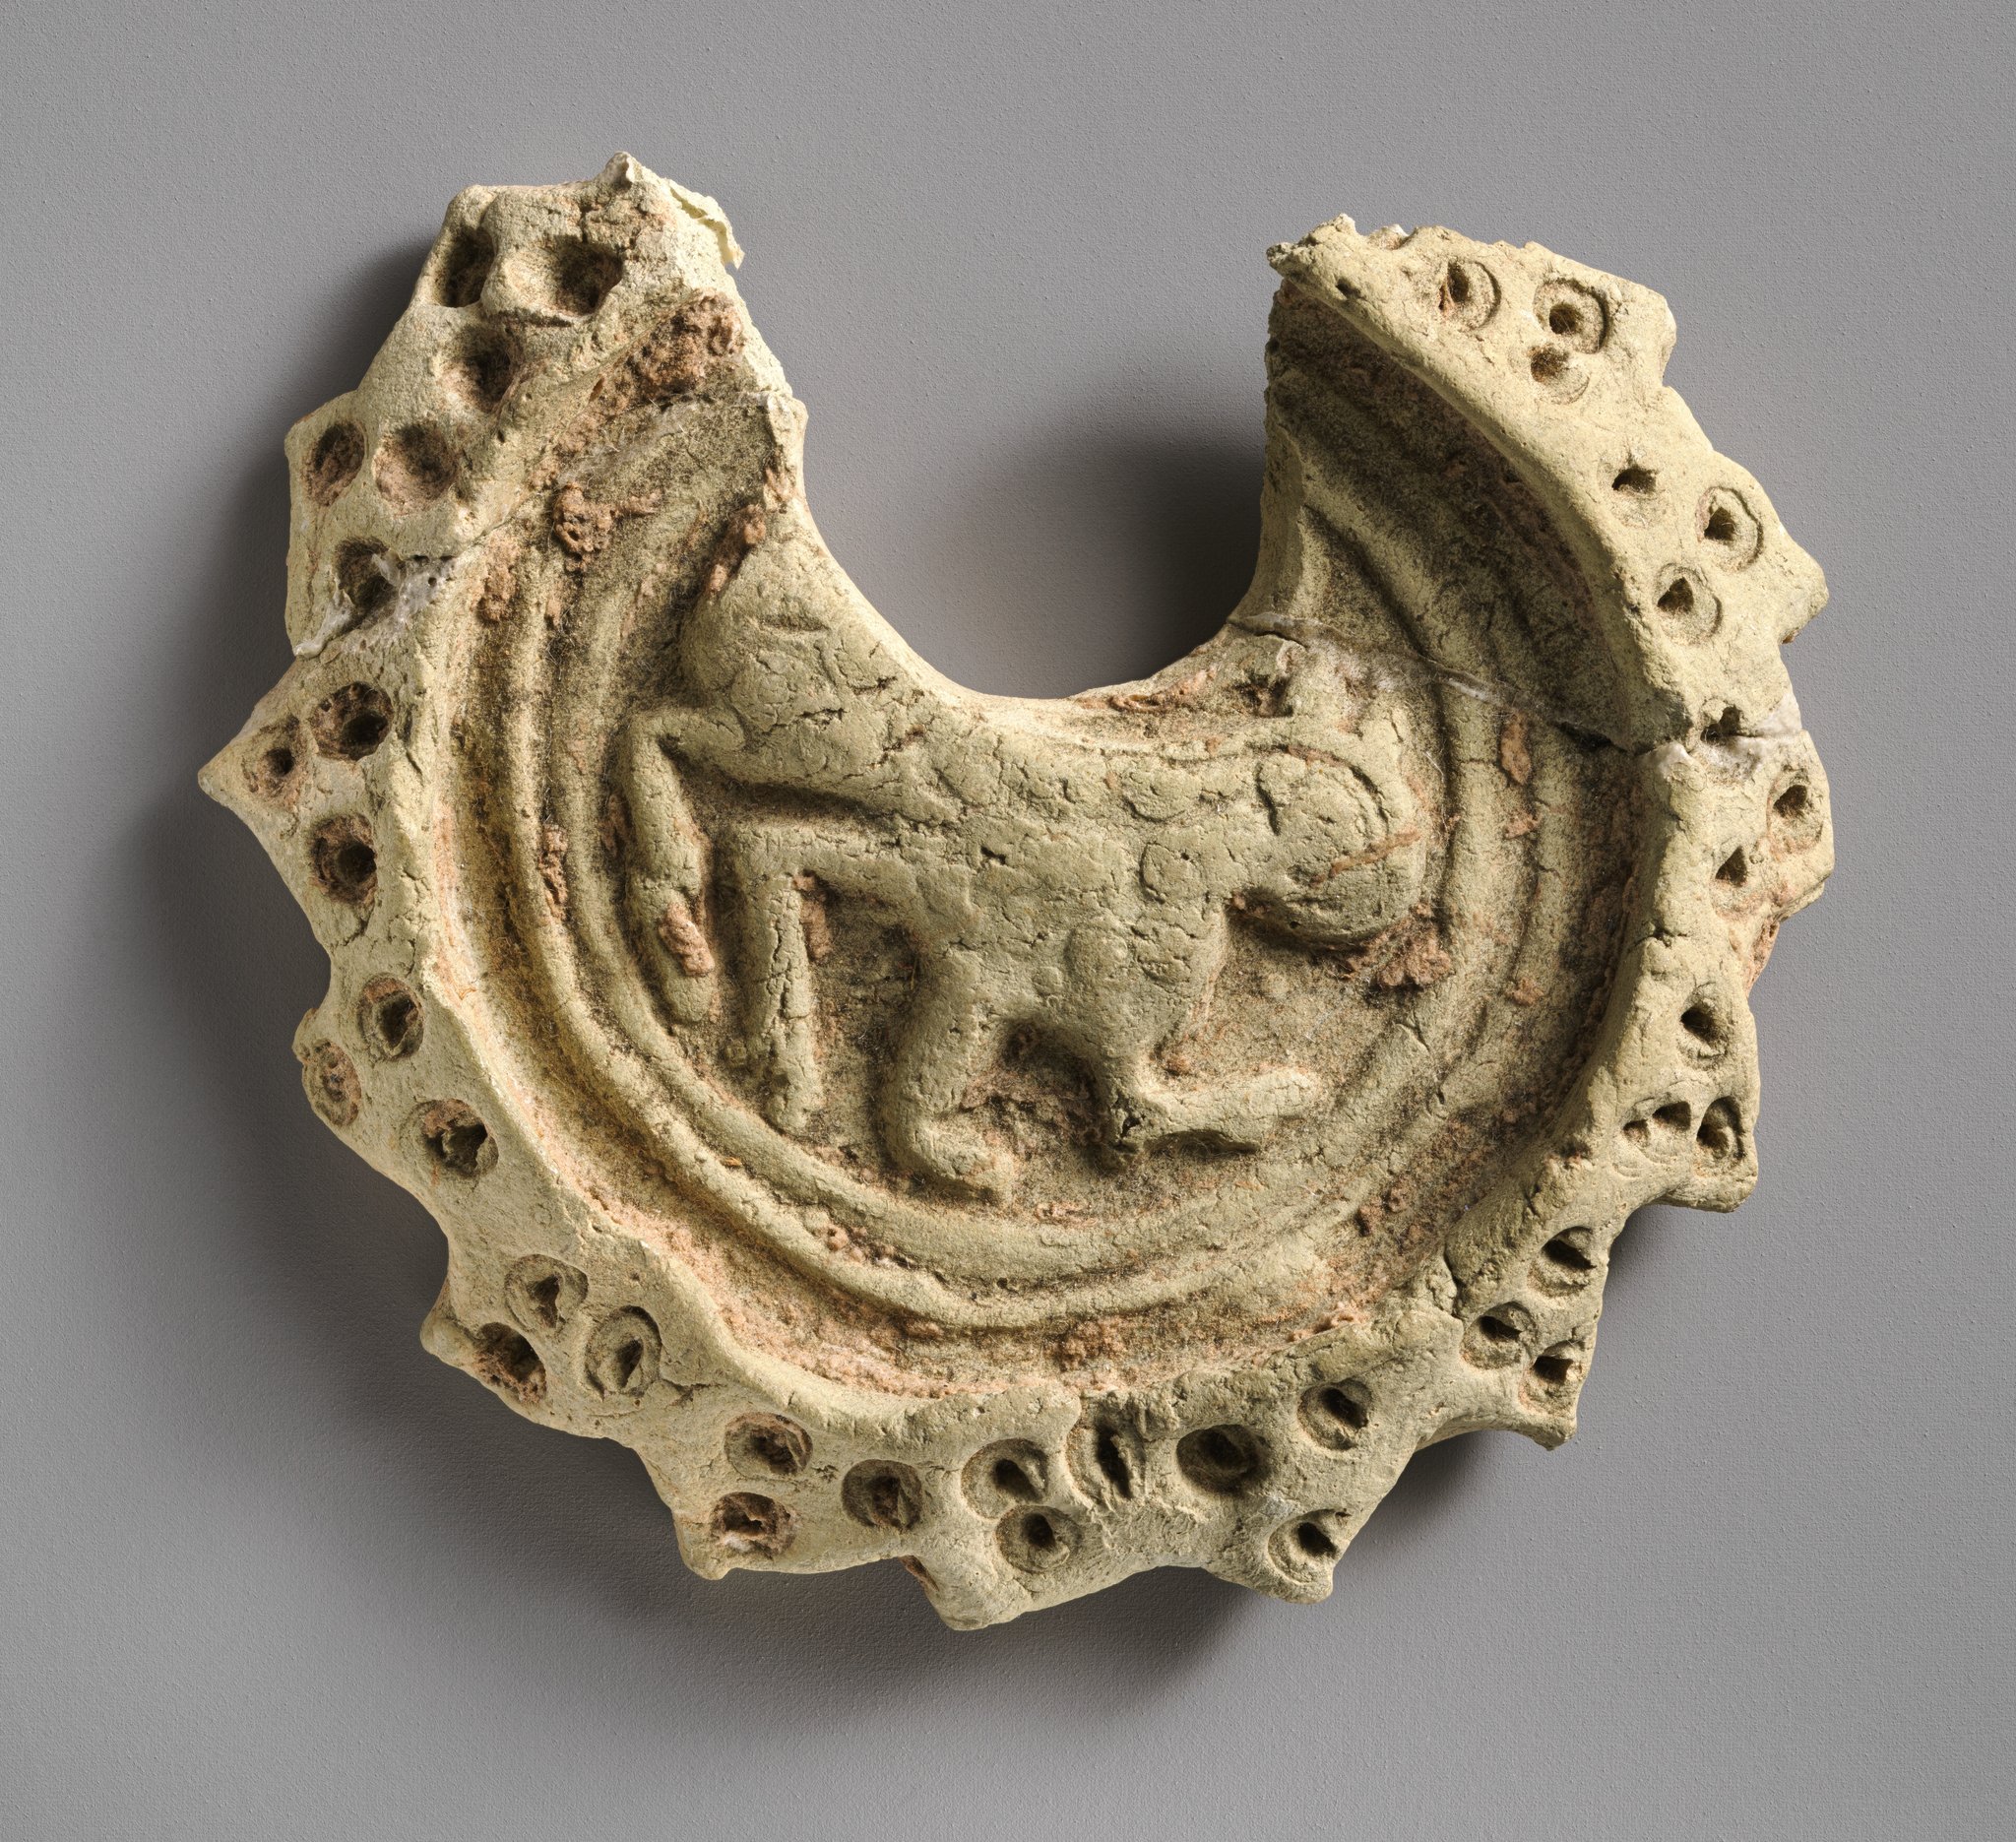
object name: vessel with lid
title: Vessel lid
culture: sasanian or islamic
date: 501-800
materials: ceramic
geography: iran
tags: animals